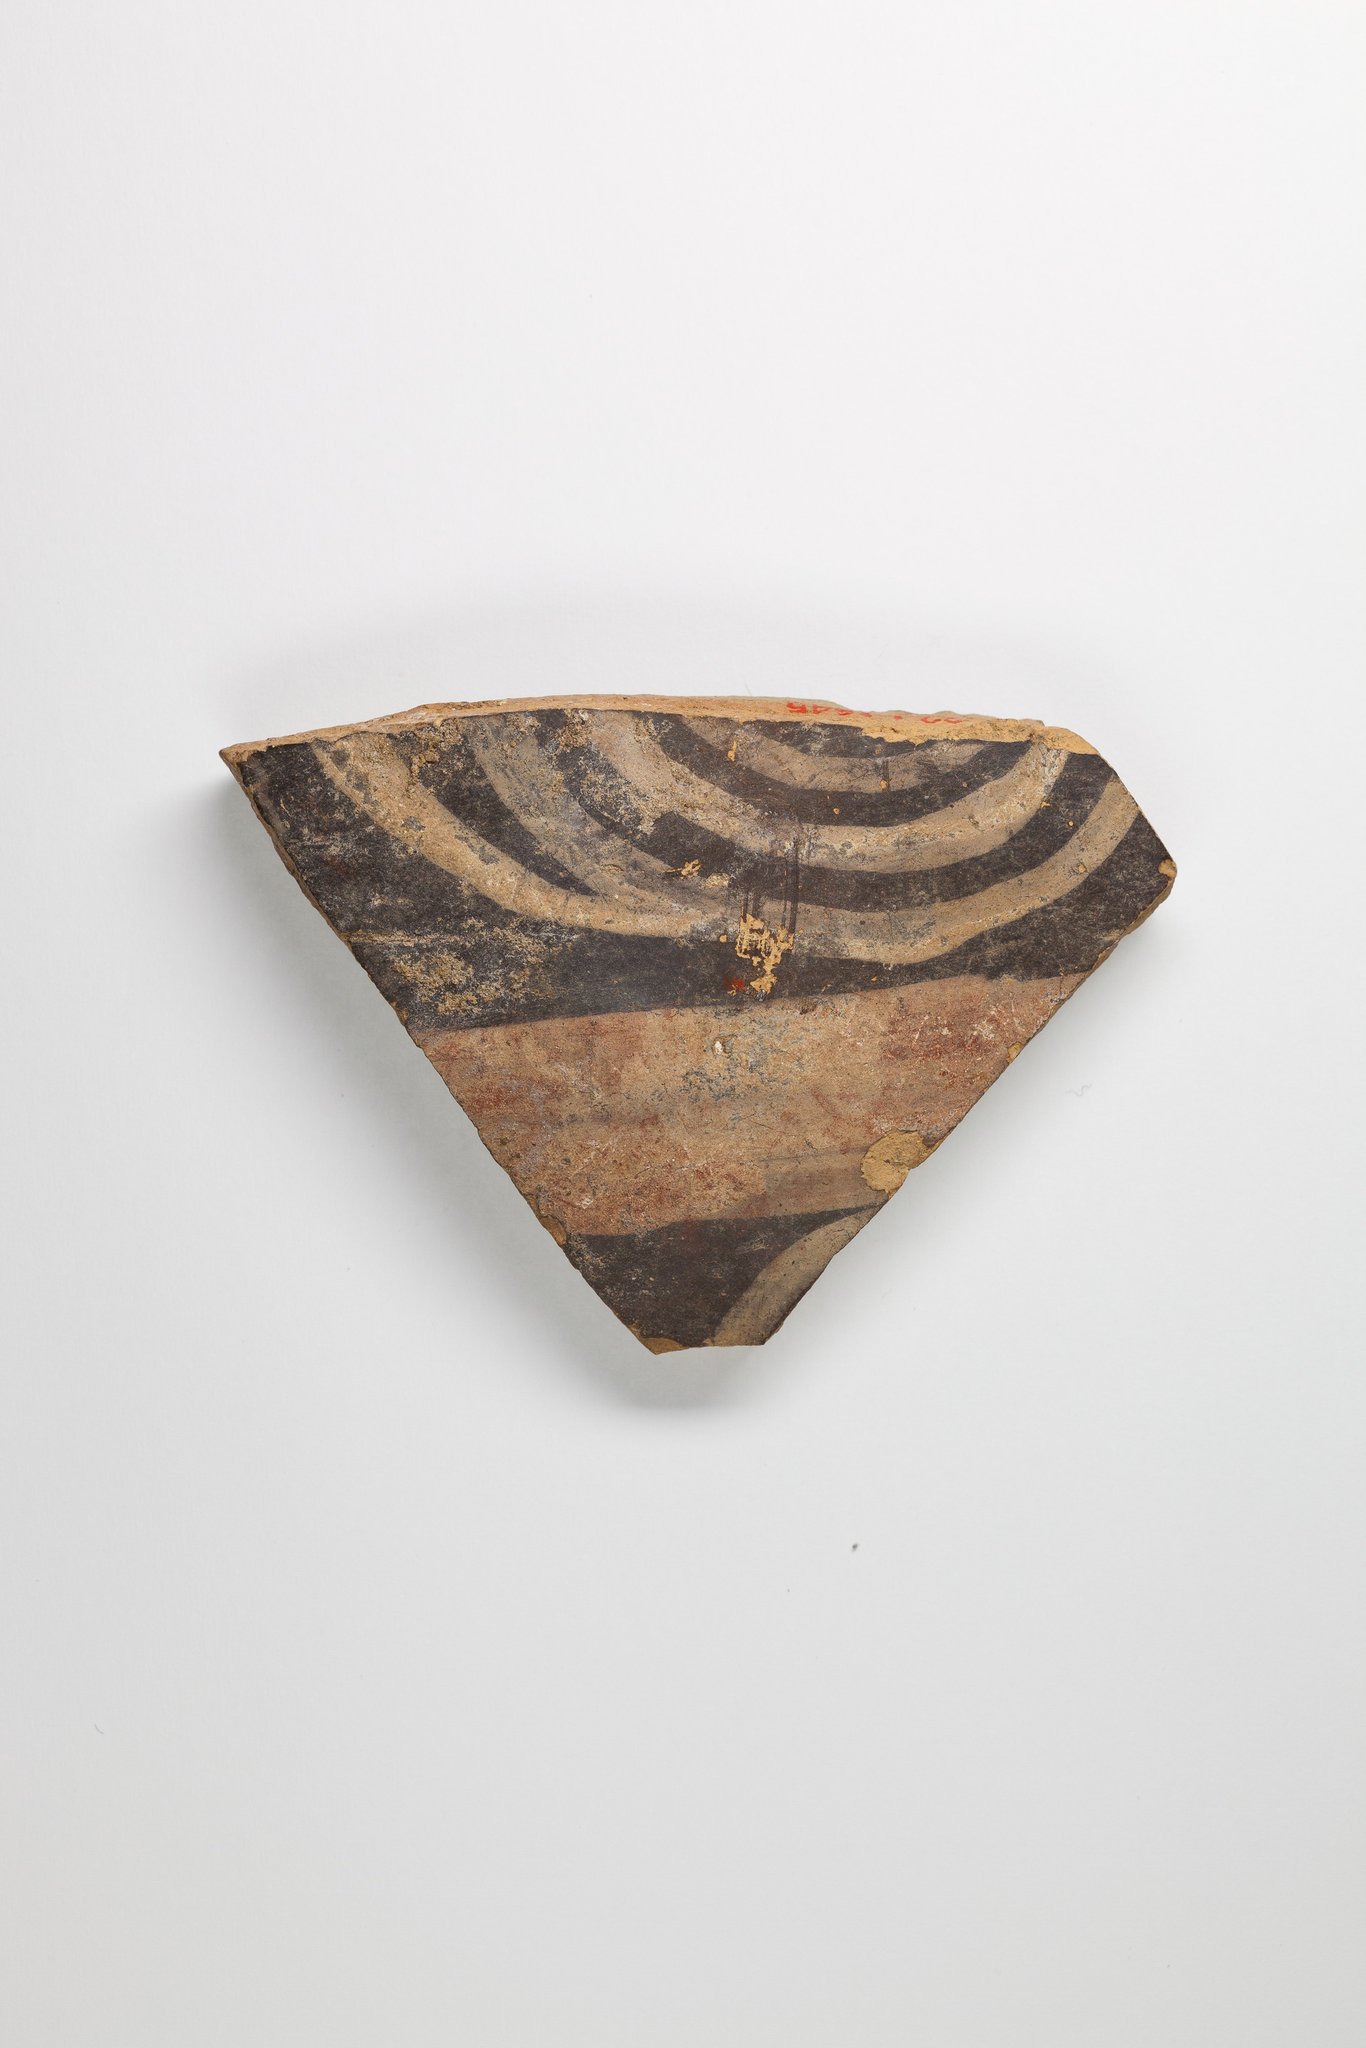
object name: minoan body sherd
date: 1981-1640 BCE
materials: pottery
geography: egypt